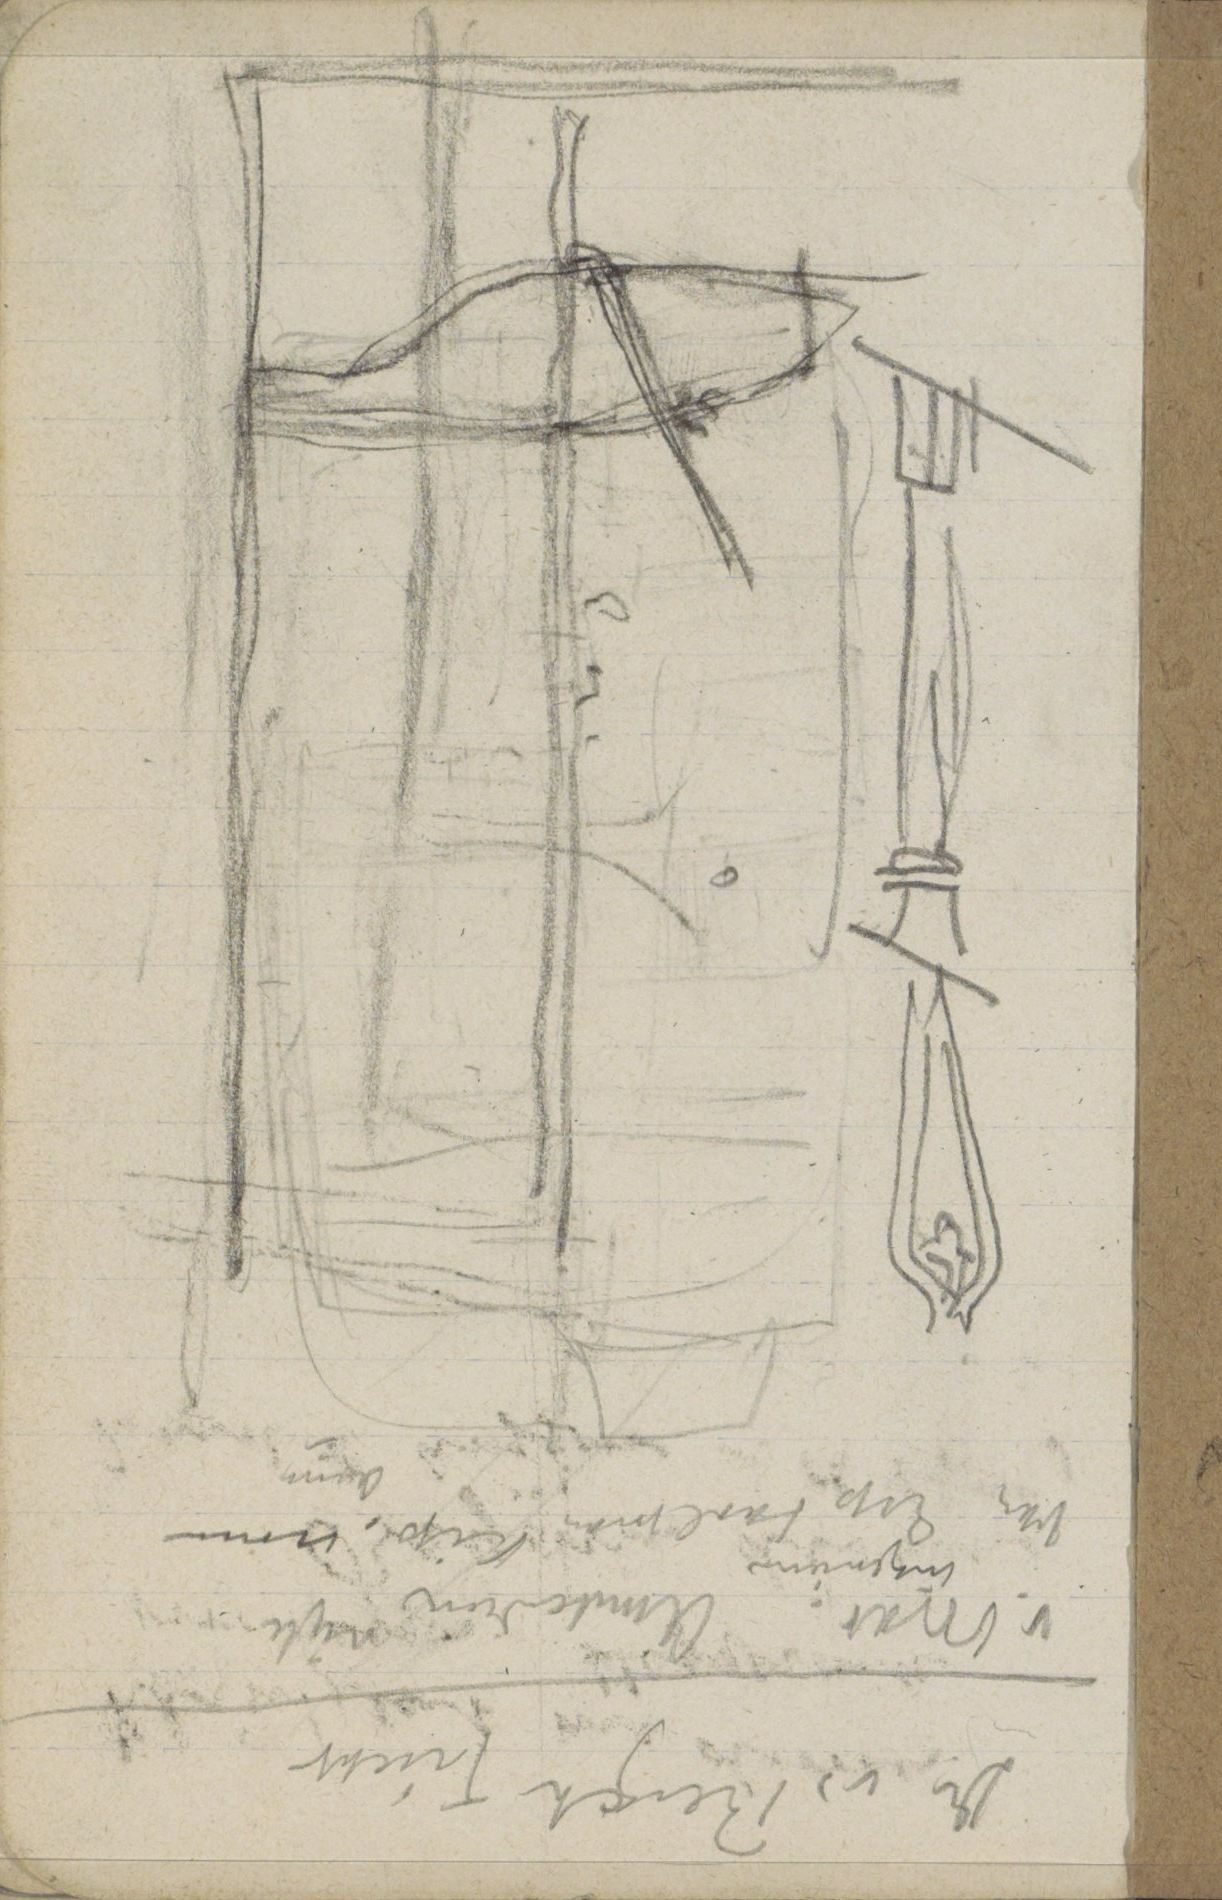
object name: sketchbook leaf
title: Studies, mogelijk architectuurstudies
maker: george hendrik breitner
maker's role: draughtsman, painter, print maker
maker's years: 1857-1923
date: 1903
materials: chalk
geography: amsterdam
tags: architectural detail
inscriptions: annotation: ‘[...]’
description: Pagina 83 uit een schetsboek met 32 bladen.